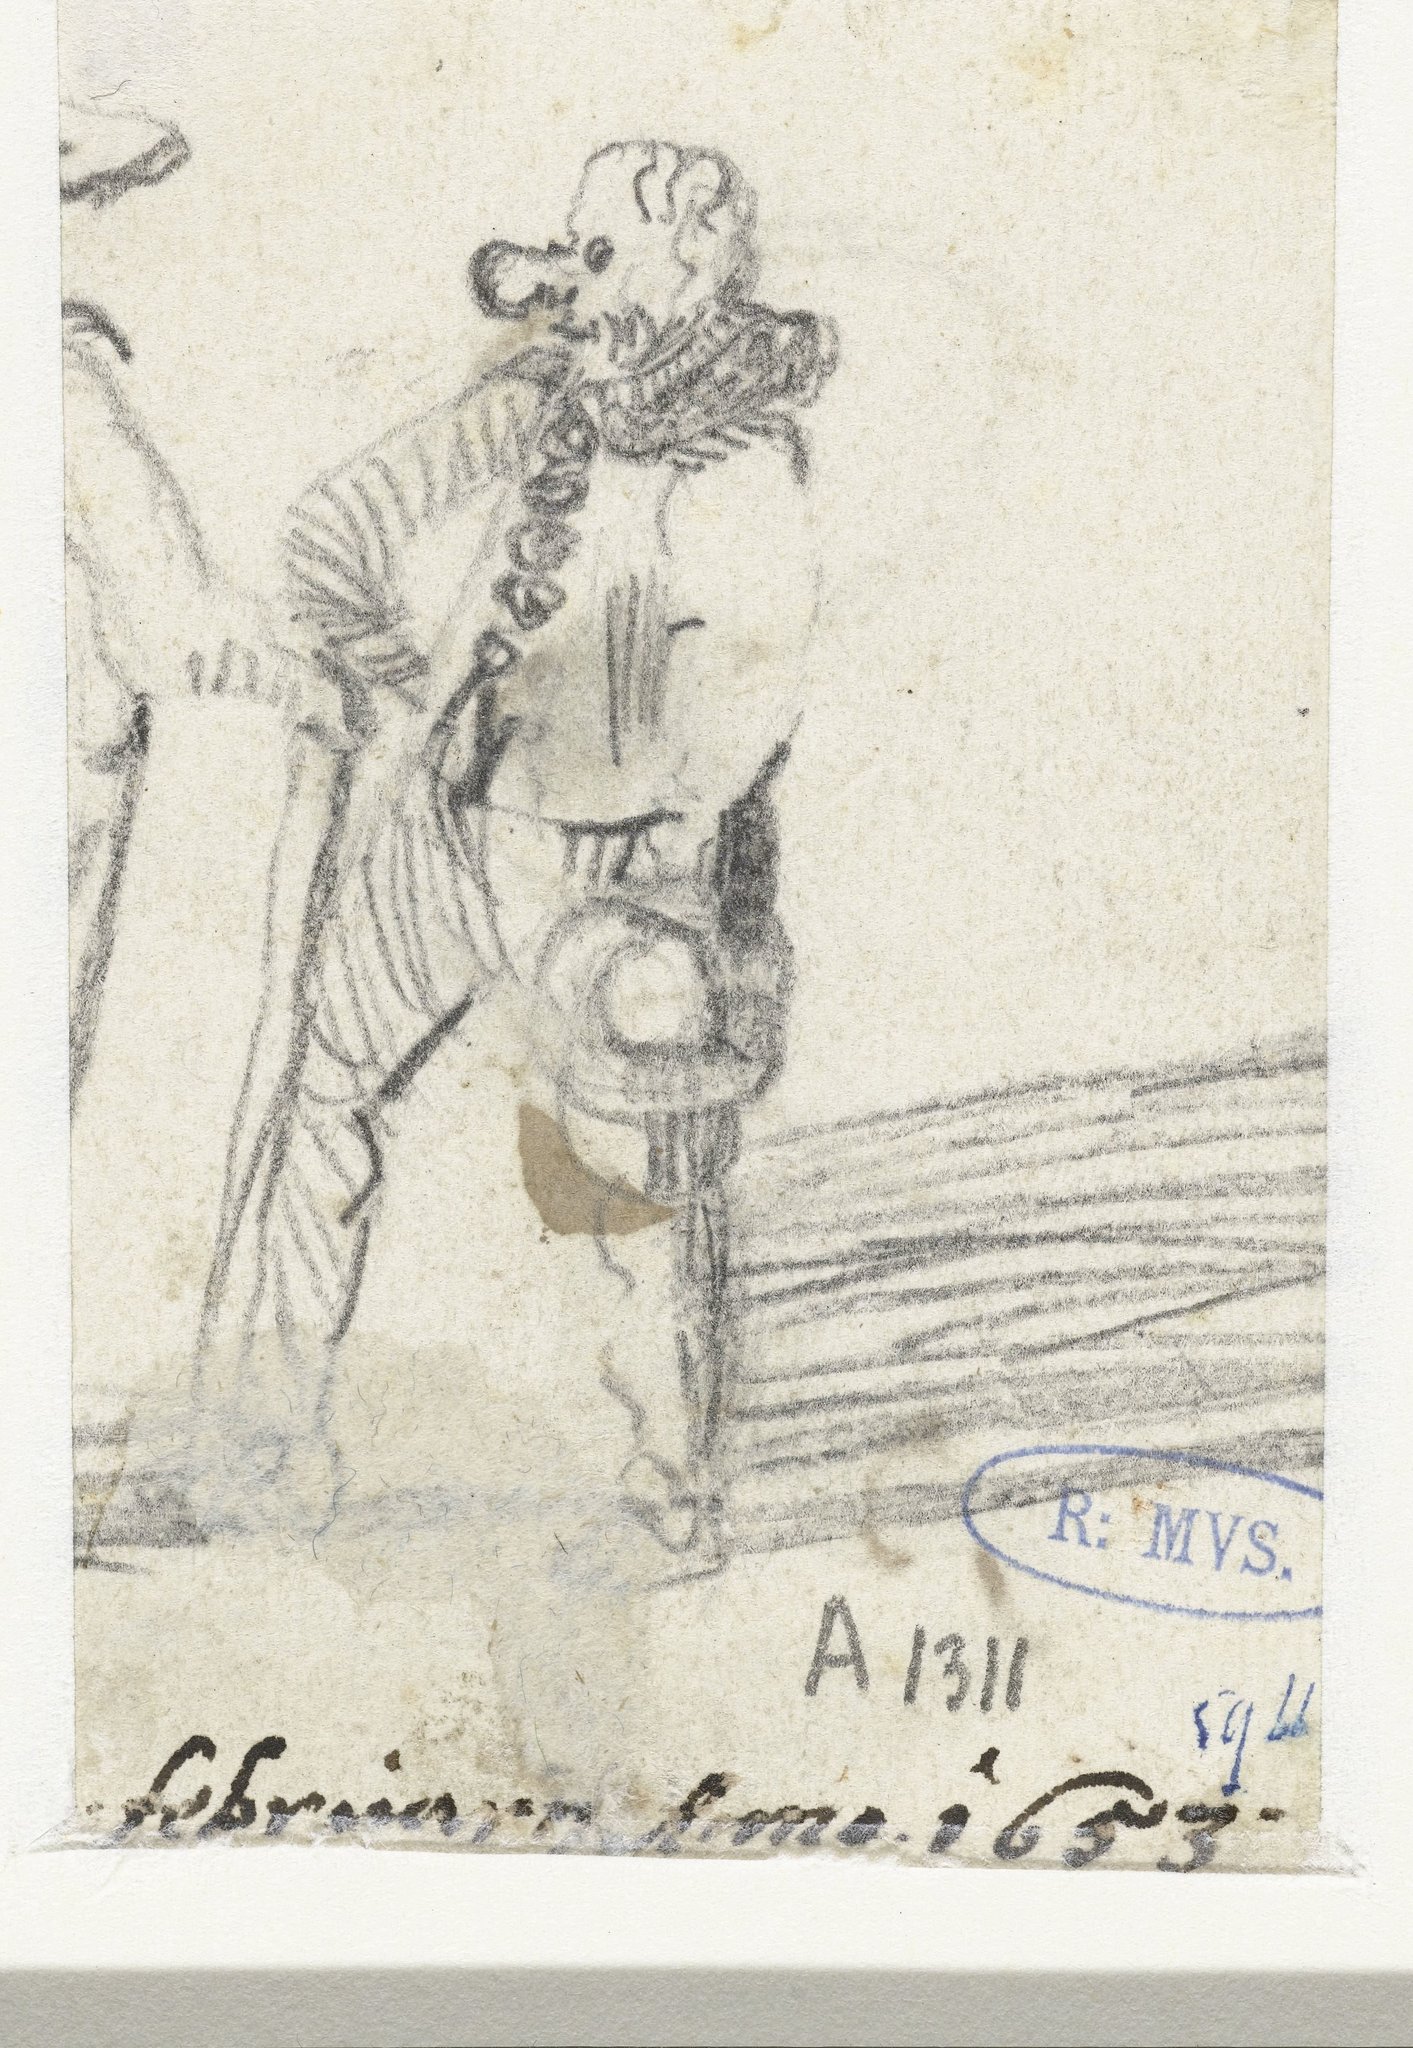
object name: drawing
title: Man met een grote neus (komediant?), pratend met een andere man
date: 1653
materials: paper, pencil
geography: zwolle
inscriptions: annotation: ‘9 februarij Anno 1653’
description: Door Harmen of Moses getekend naar eerdere tekening H 51.